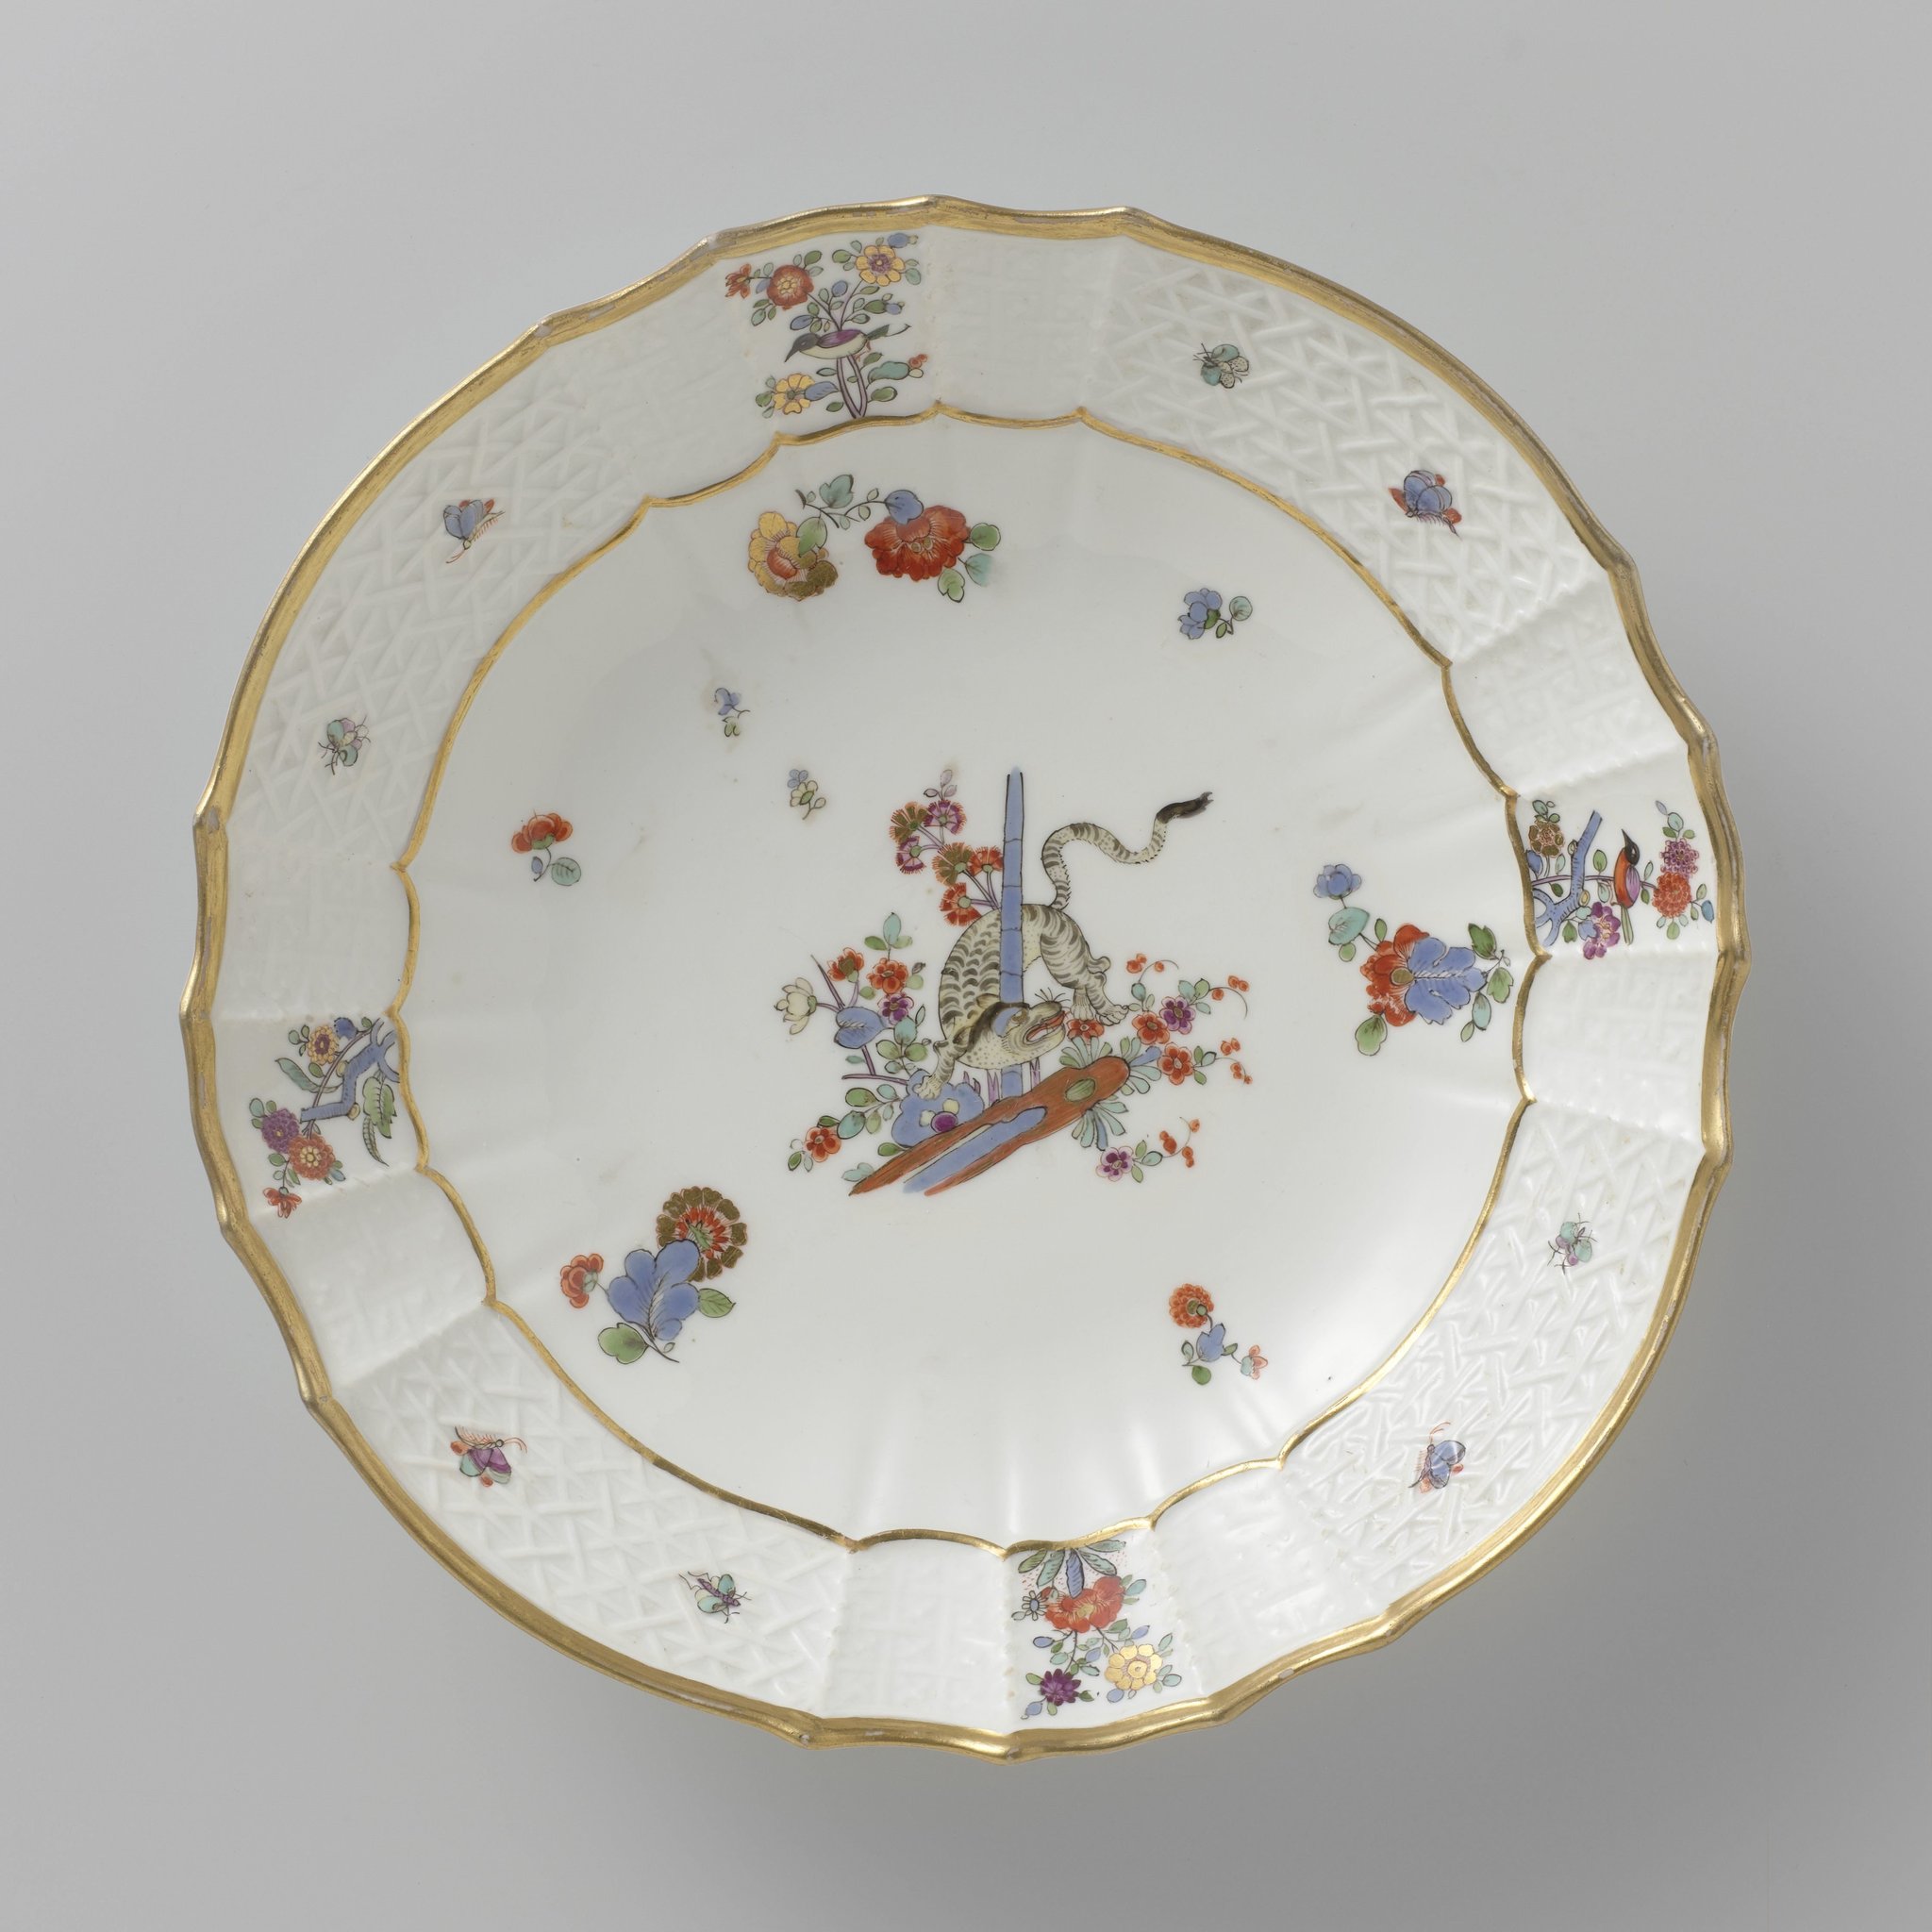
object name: platter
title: Schotel, veelkleurig beschilderd met een Kakiemon-decor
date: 1740-1745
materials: porcelain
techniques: painted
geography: meissen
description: Ronde schotel van beschilderd porselein. De schotel heeft een geribde en geschulpte rand. De schotel is beschilderd met een tijger om een bamboestengel, gestrooide Indianische Blumen, vlinders en takken met vogels. De rand is versierd met het 'Altbrandenstein'-patroon. De schotel is gemerkt.